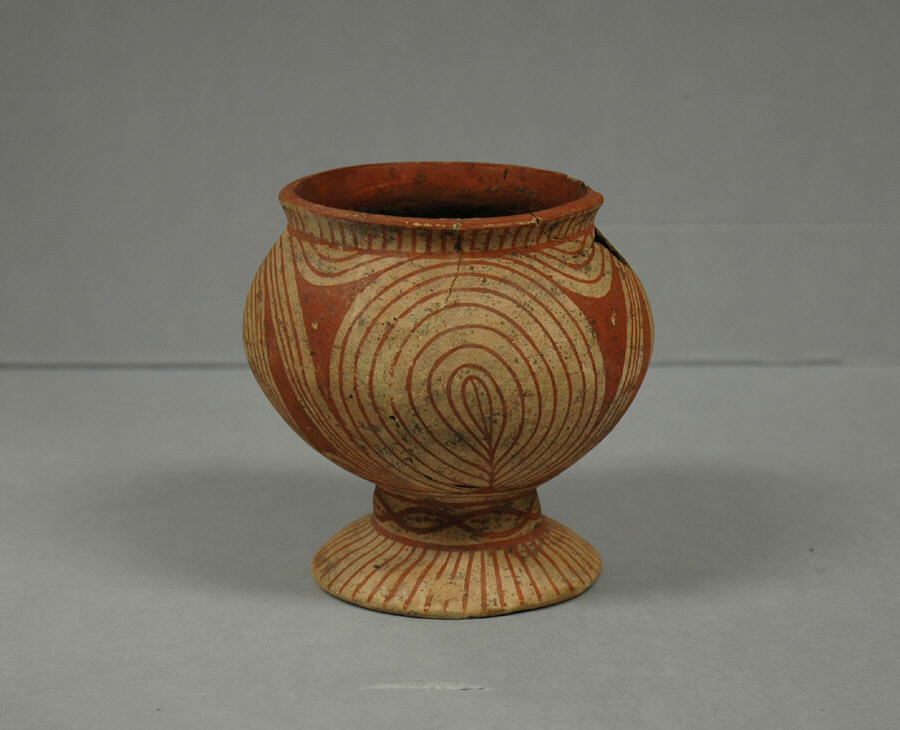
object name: vessel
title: Vessel with Flaring Foot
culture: thai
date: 300 BCE-200 CE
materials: earthenware